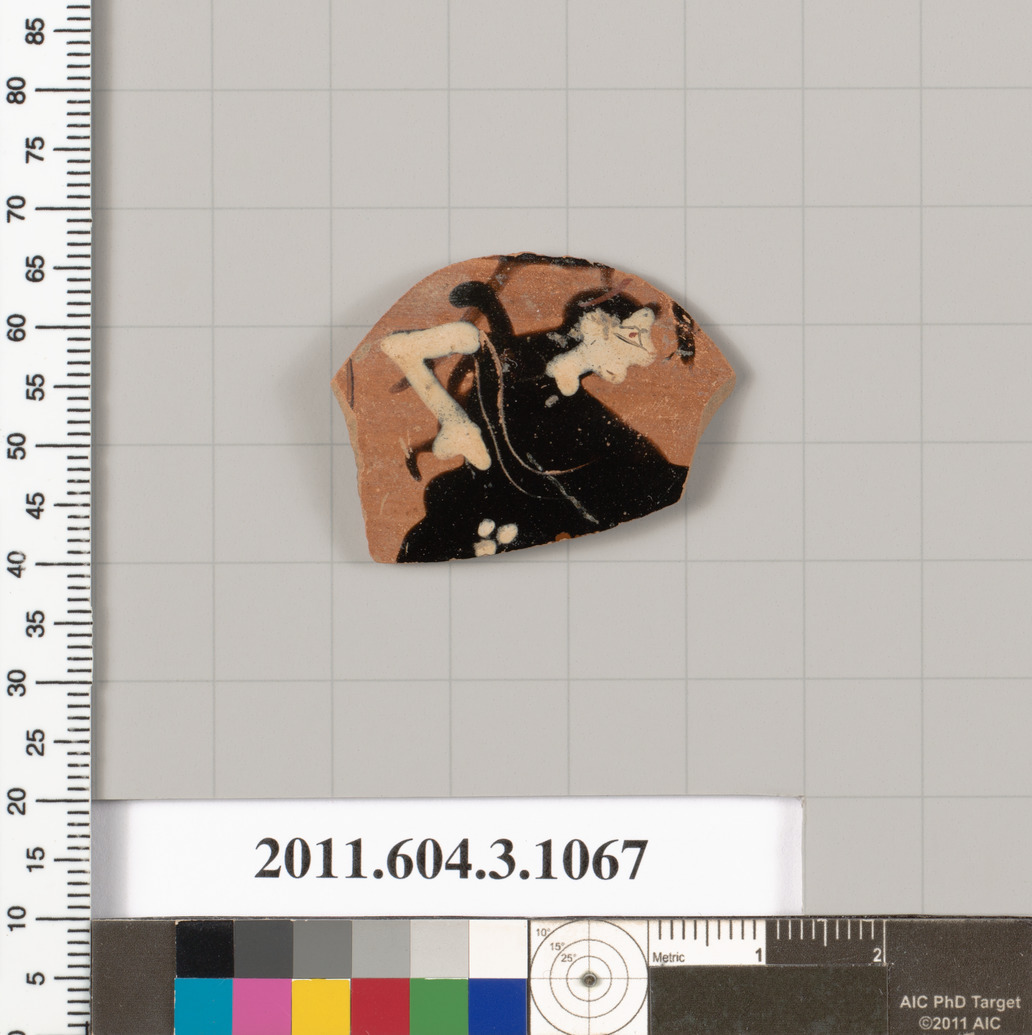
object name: mastoid fragment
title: Terracotta fragment of a mastoid (drinking cup with narrow base)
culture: greek, attic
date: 534-468 BCE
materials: terracotta